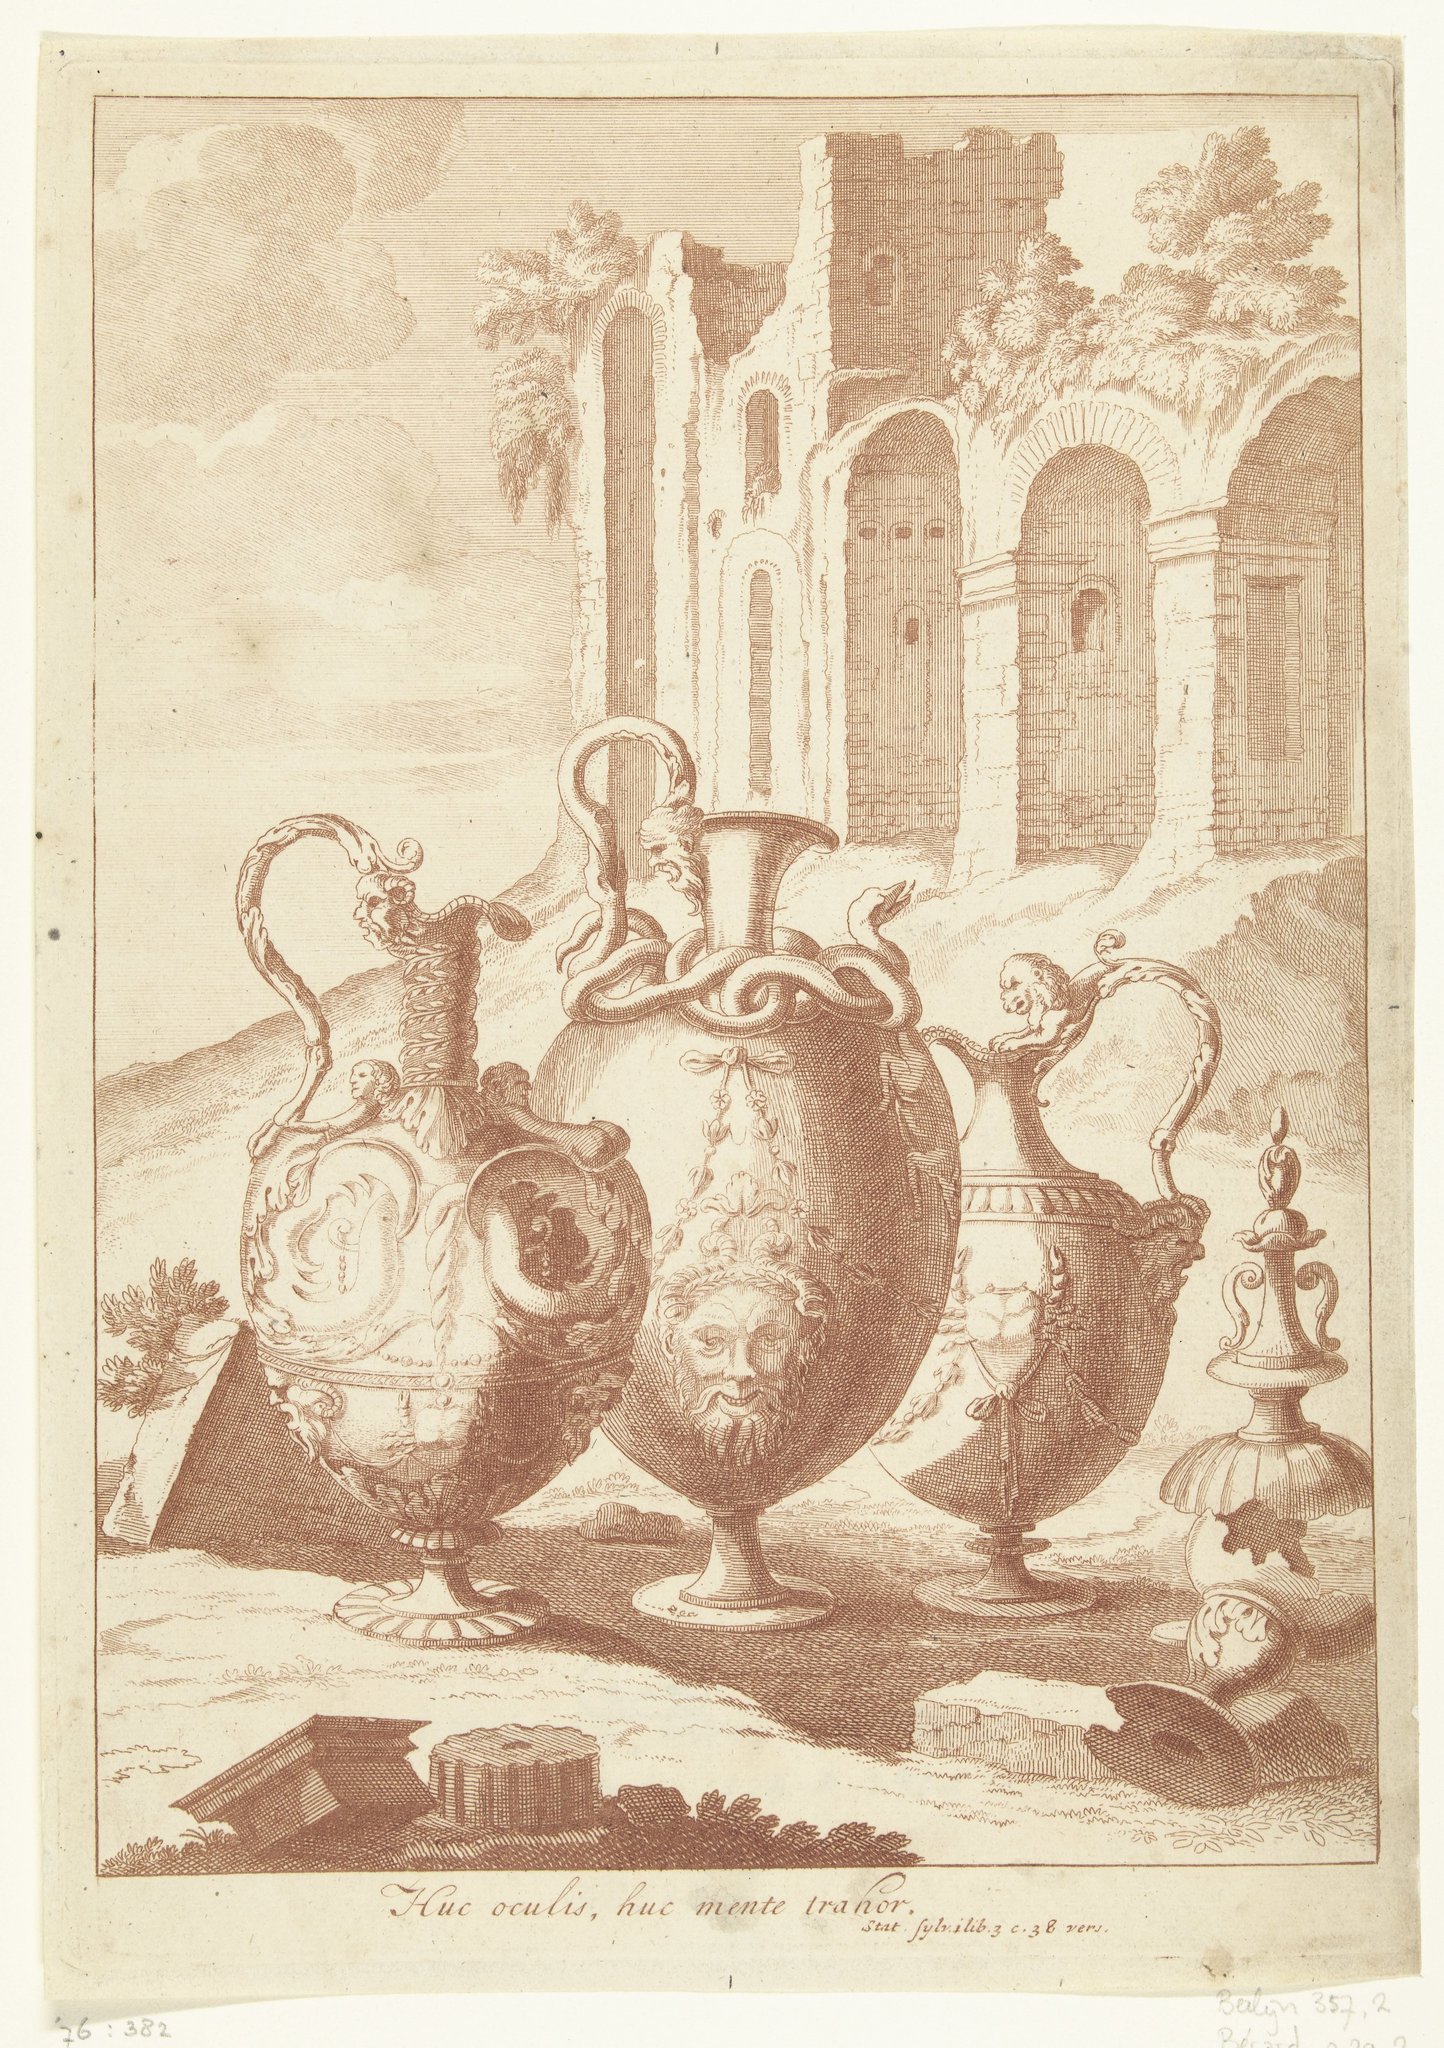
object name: ornament print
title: Vazen en kandelaars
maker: Anonymous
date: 1688-1697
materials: paper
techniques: etching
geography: nijmegen